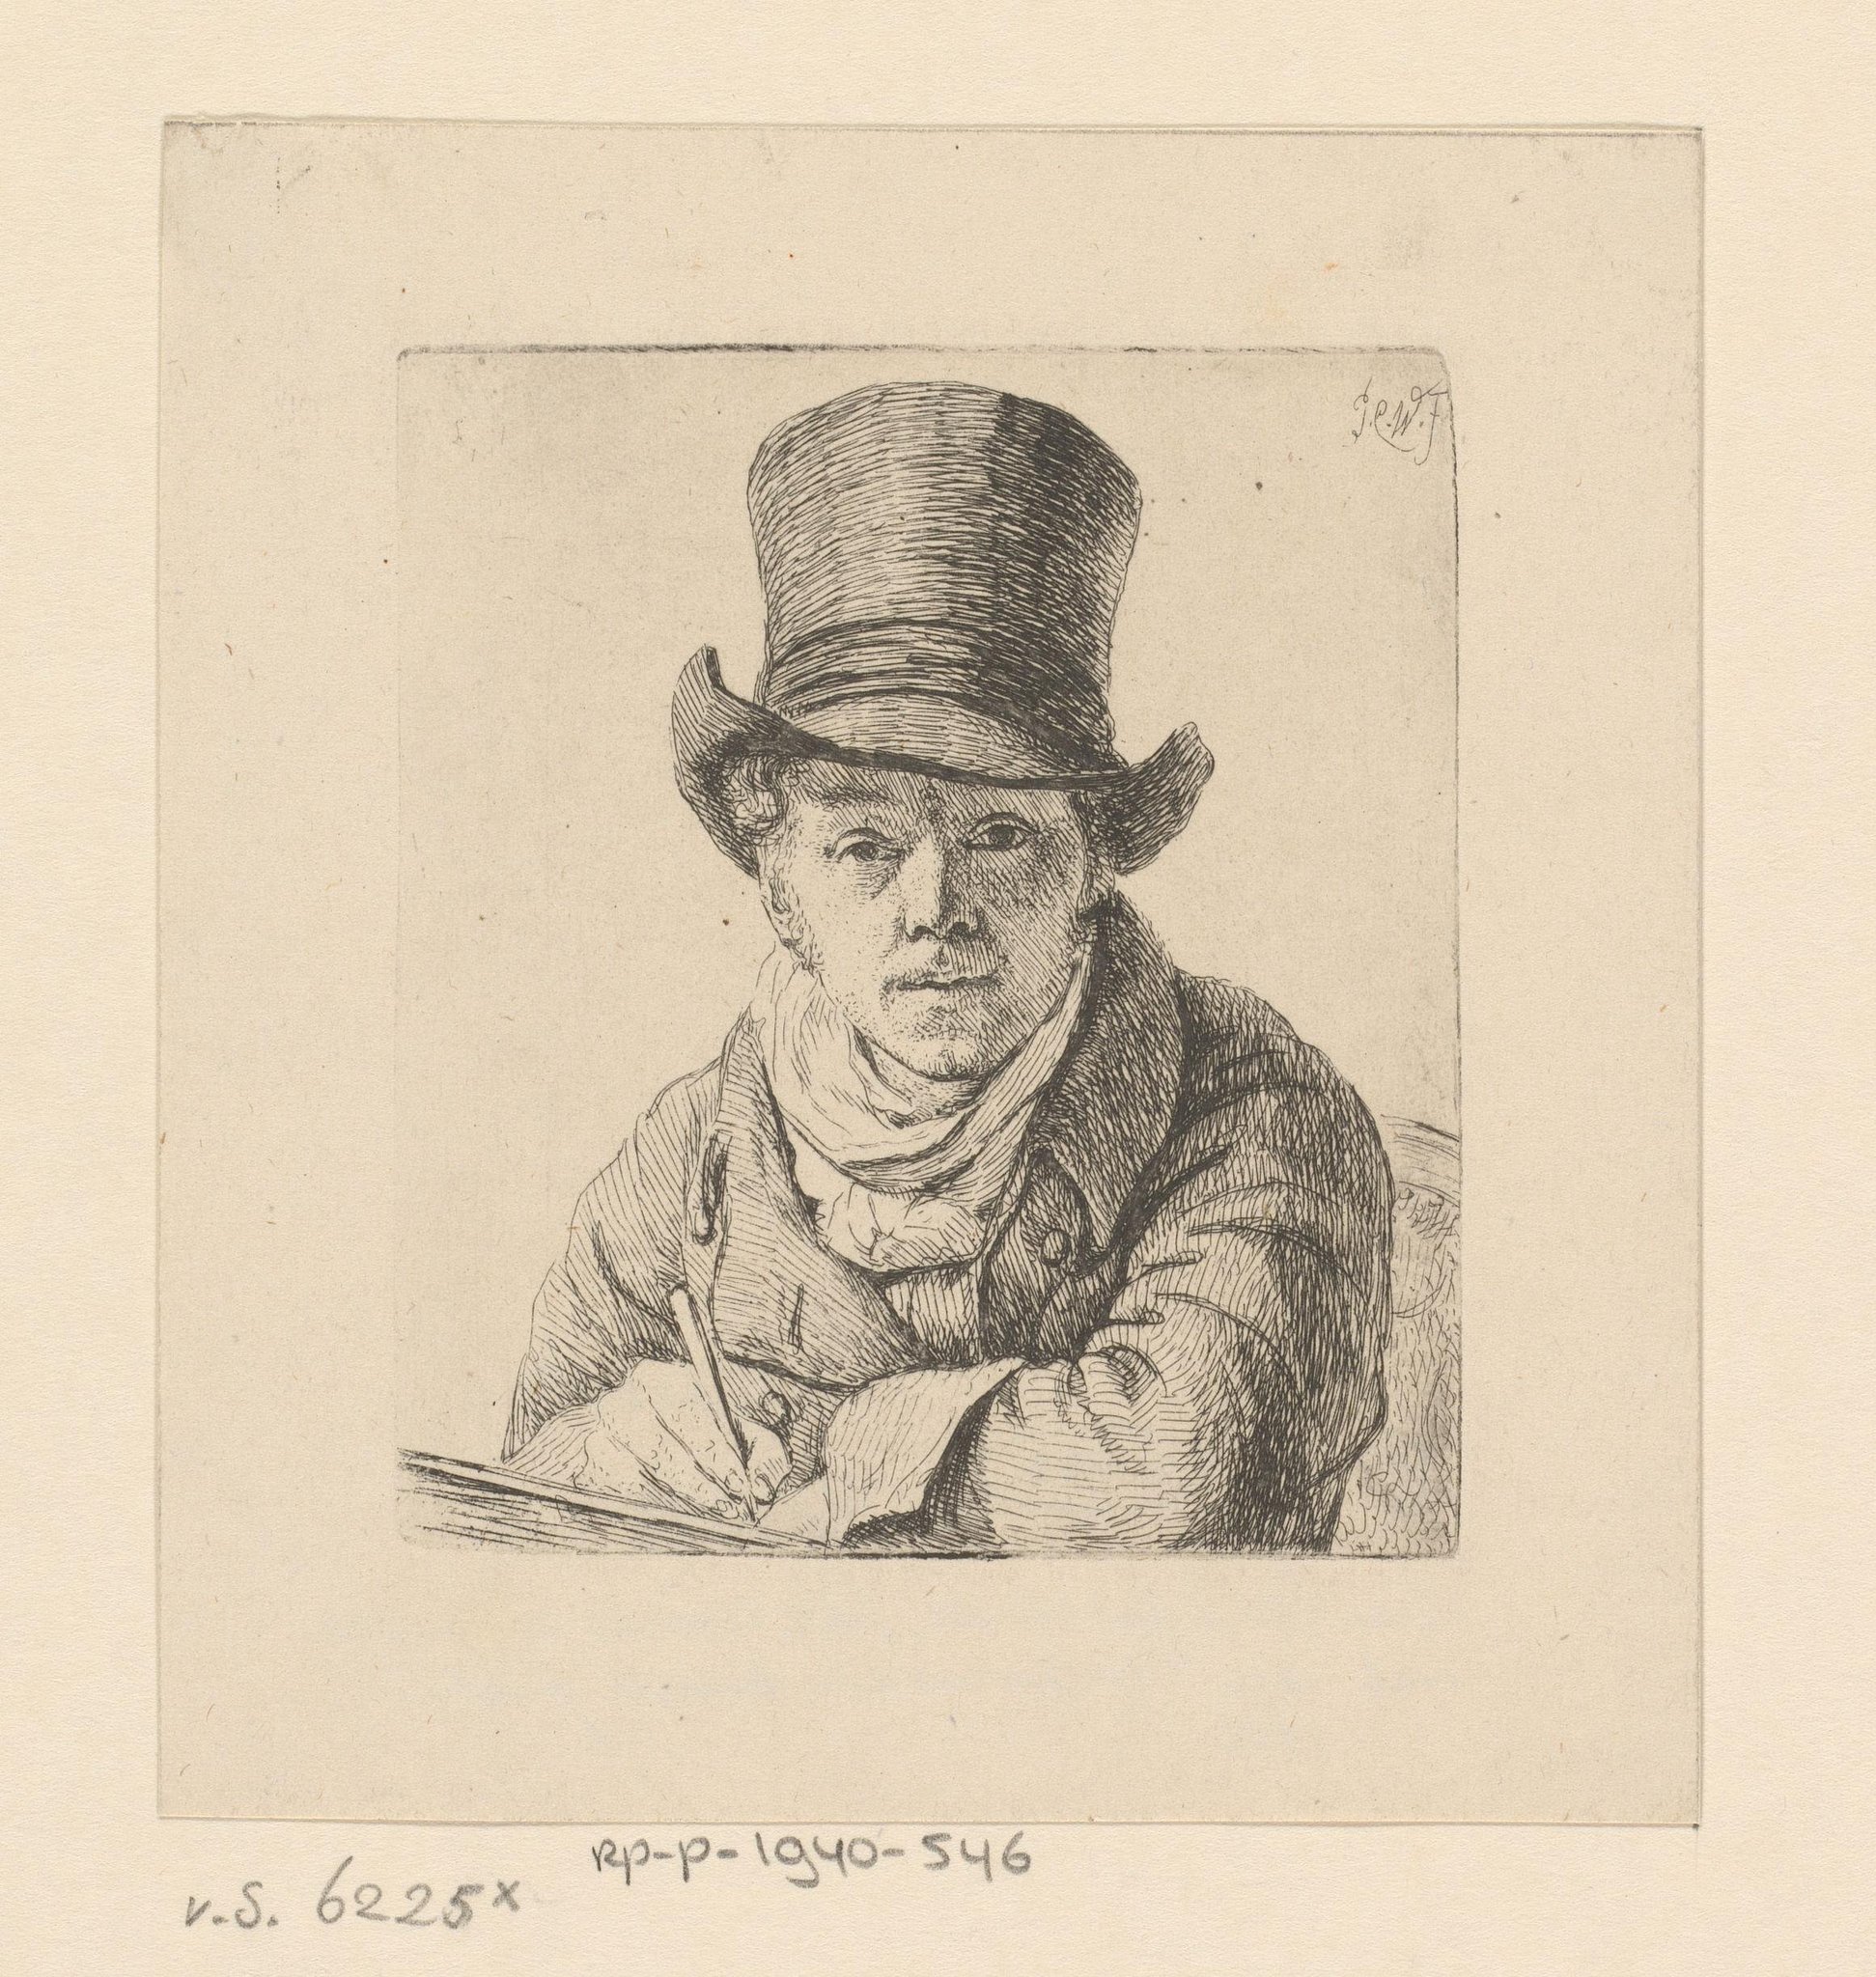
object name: print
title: Zelfportret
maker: pieter christoffel wonder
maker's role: draughtsman, painter, print maker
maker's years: 1780-1852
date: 1800-1852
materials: paper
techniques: etching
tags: utrecht, amsterdam, painter, print maker, pieter christoffel wonder, historical persons, portrait, self-portrait of artist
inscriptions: collector's mark: Lugt 2760, collector's mark: Lugt 2228